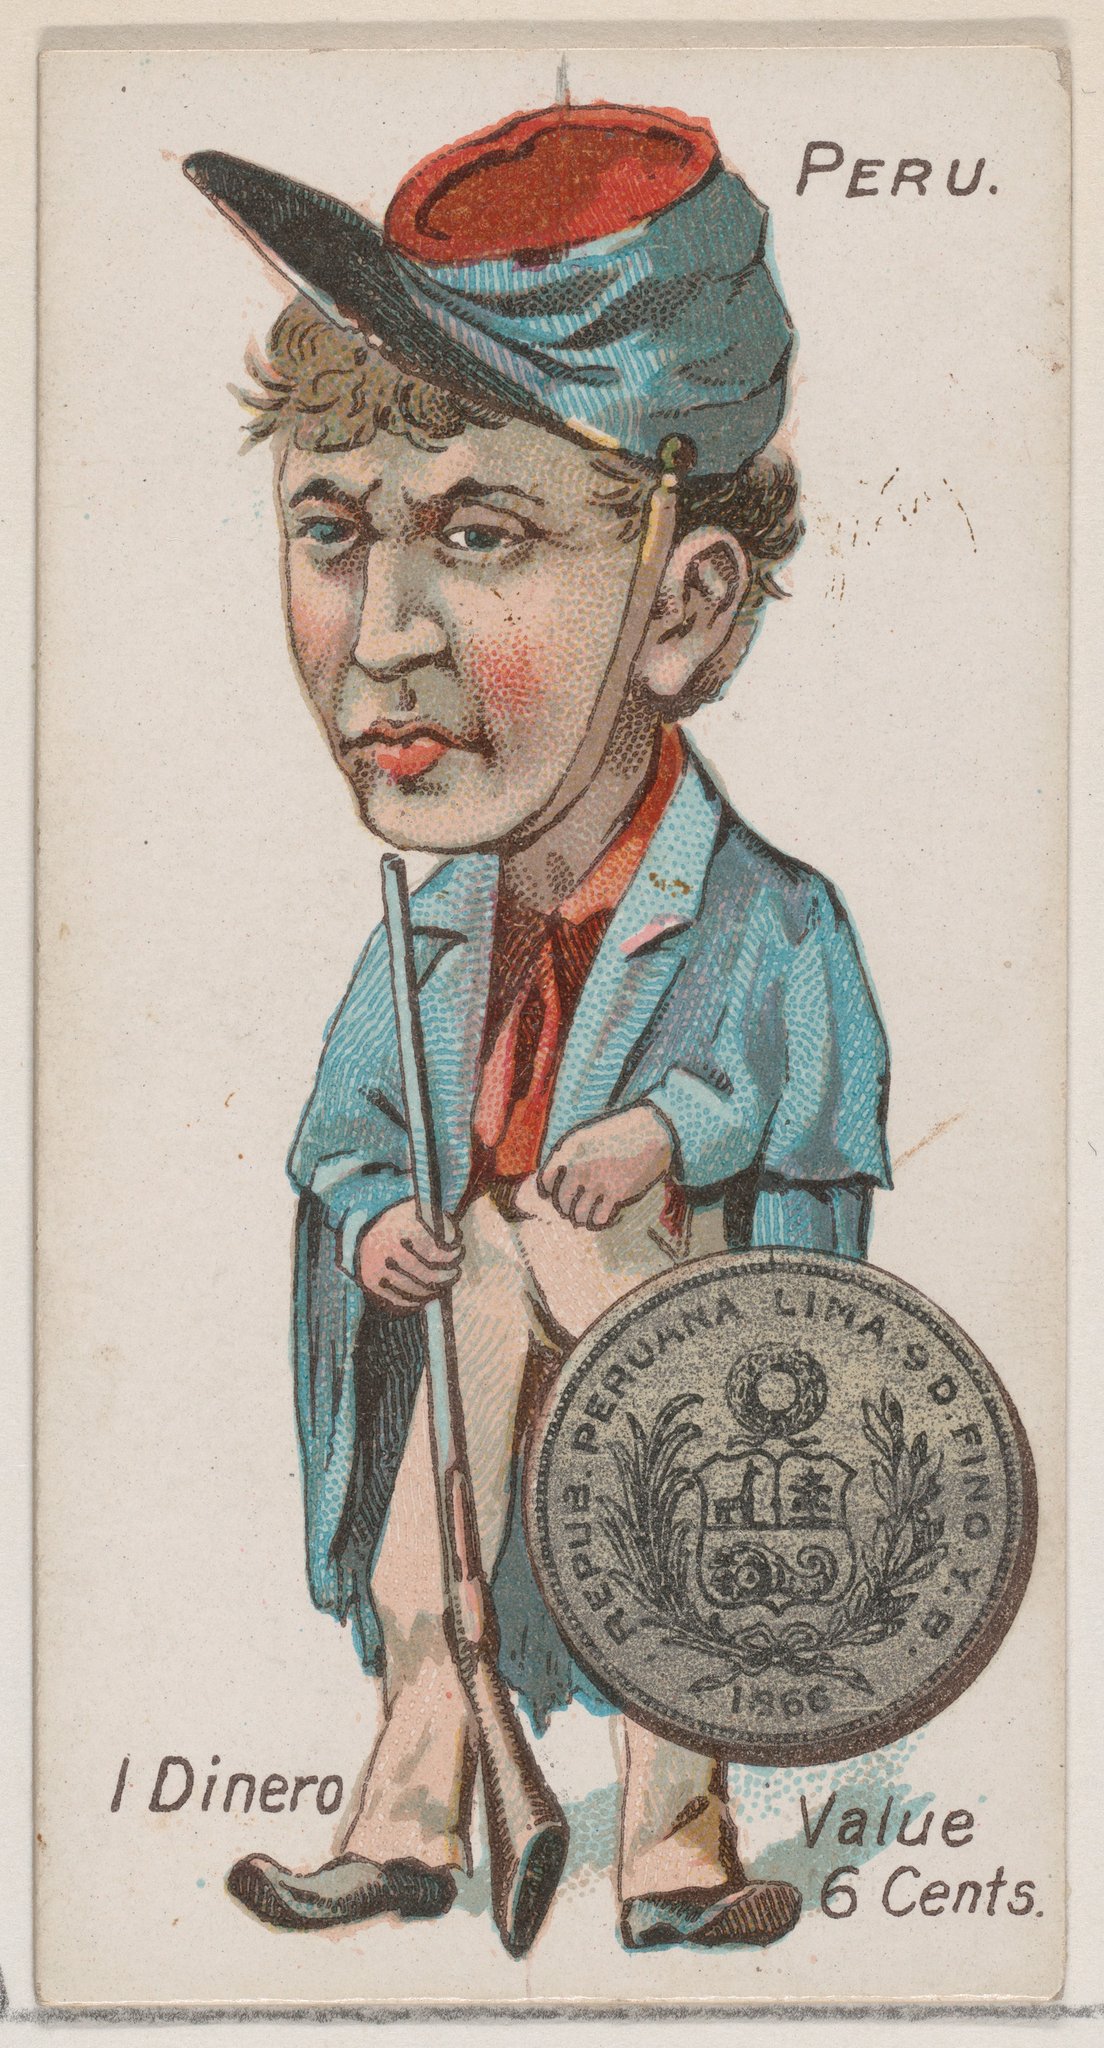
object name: print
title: Peru, 1 Dinero, from the series Coins of All Nations (N72, variation 1) for Duke brand cigarettes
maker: w. duke, sons & co.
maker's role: publisher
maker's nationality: american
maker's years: 1870-1920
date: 1889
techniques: color lithograph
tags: men,coins